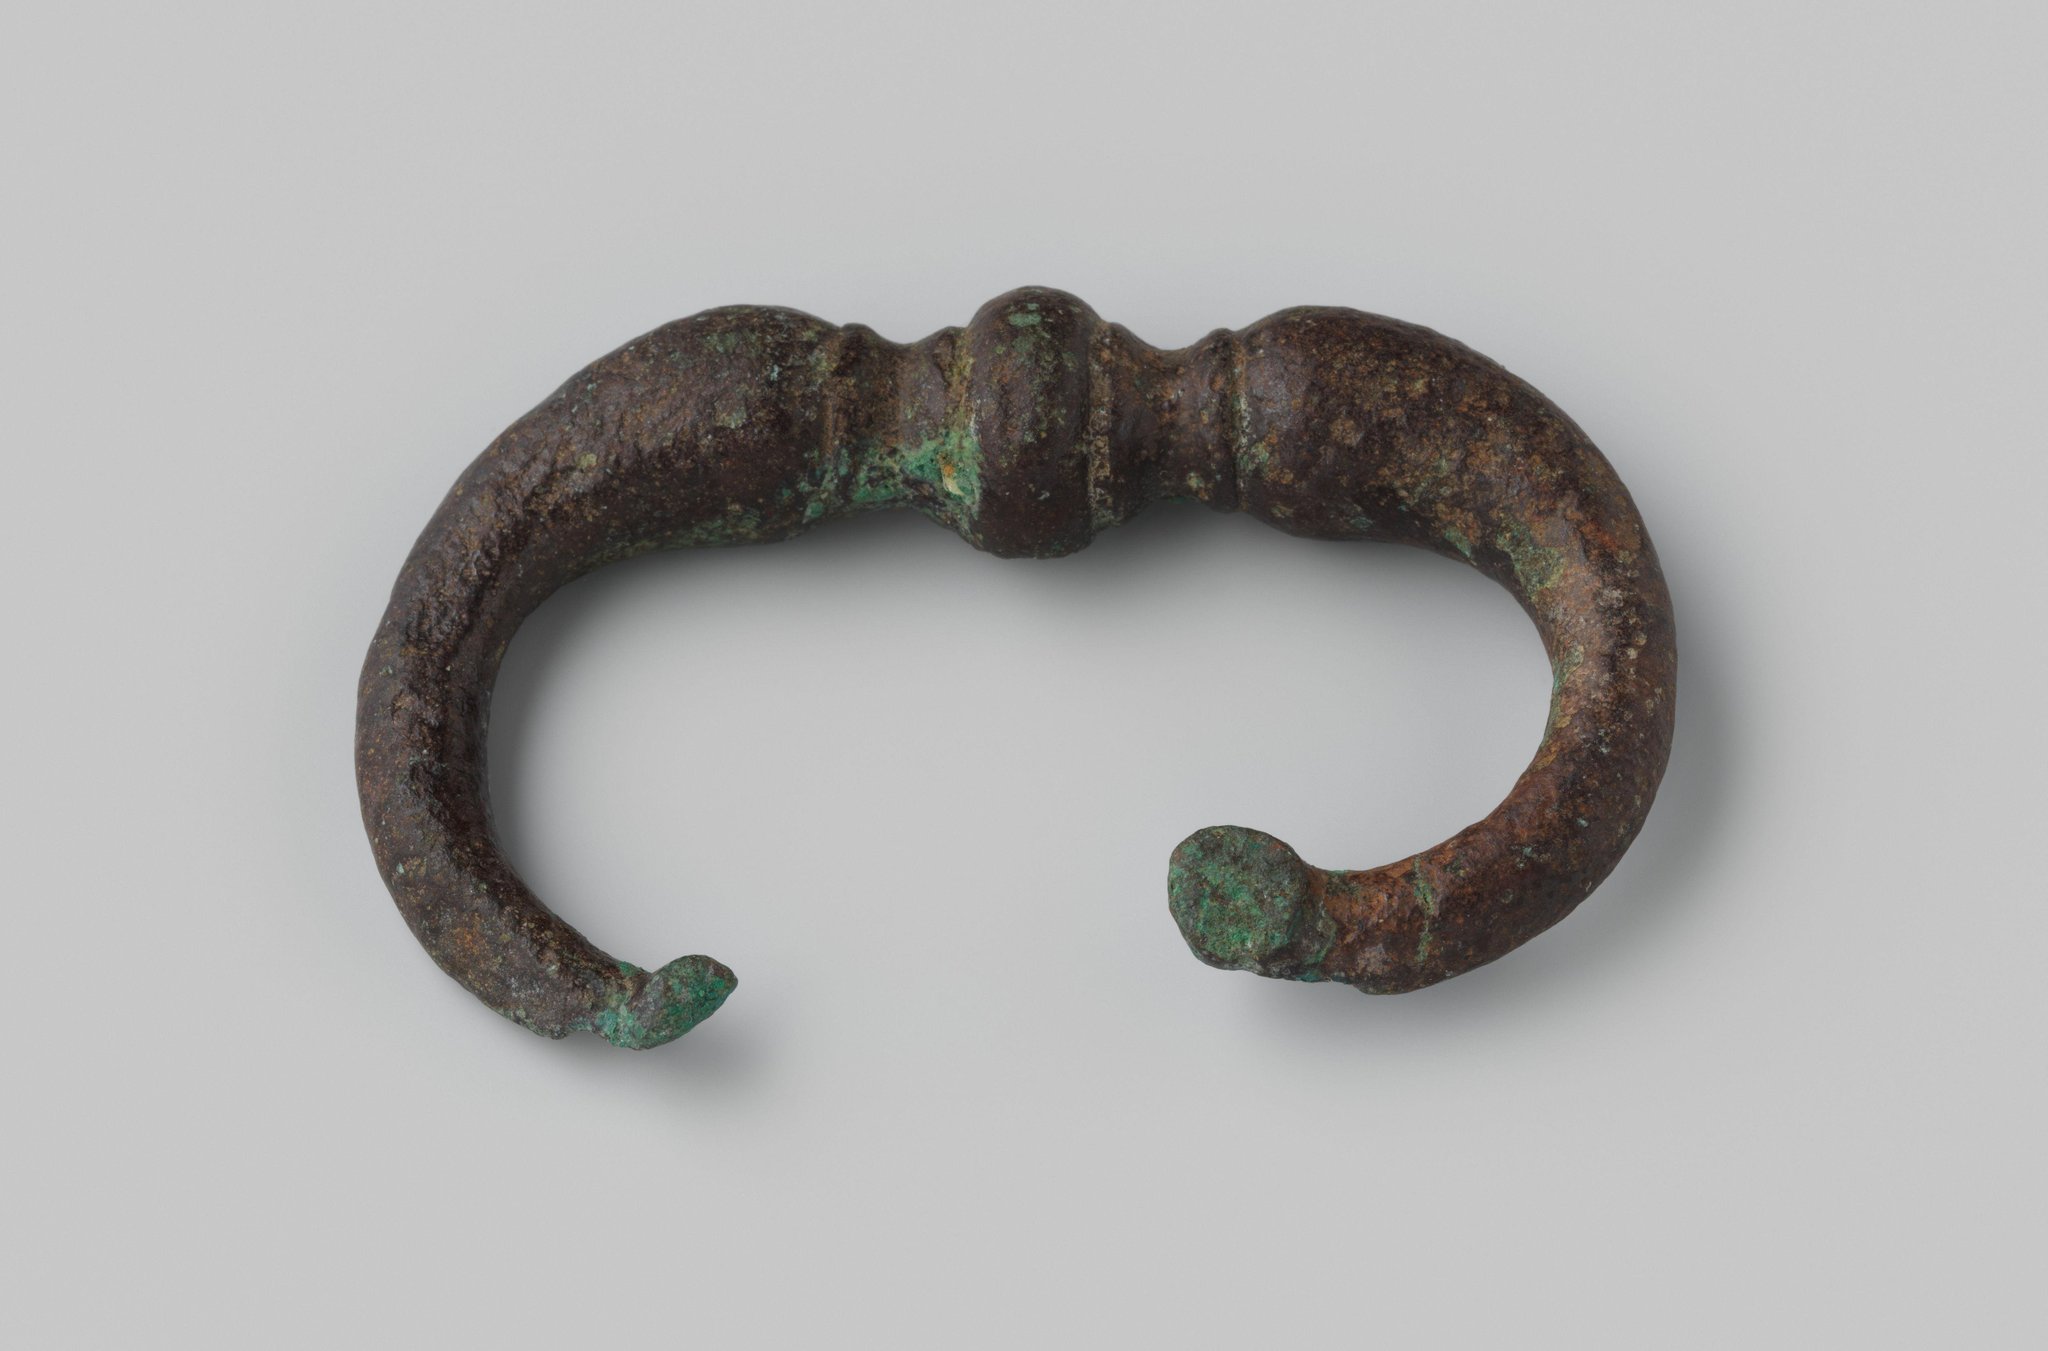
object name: bail handle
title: Beugelhandvat uit het wrak van de Oost-Indiëvaarder Hollandia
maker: Anonymous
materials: copper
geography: netherlands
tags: verenigde oostindische compagnie, hollandia (schip), annet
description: Fittings, handles, bail handle; eroded: oval, circular in section, central flattened knop, tapering, incurved ends broken off (originally forming right-angled stubs).